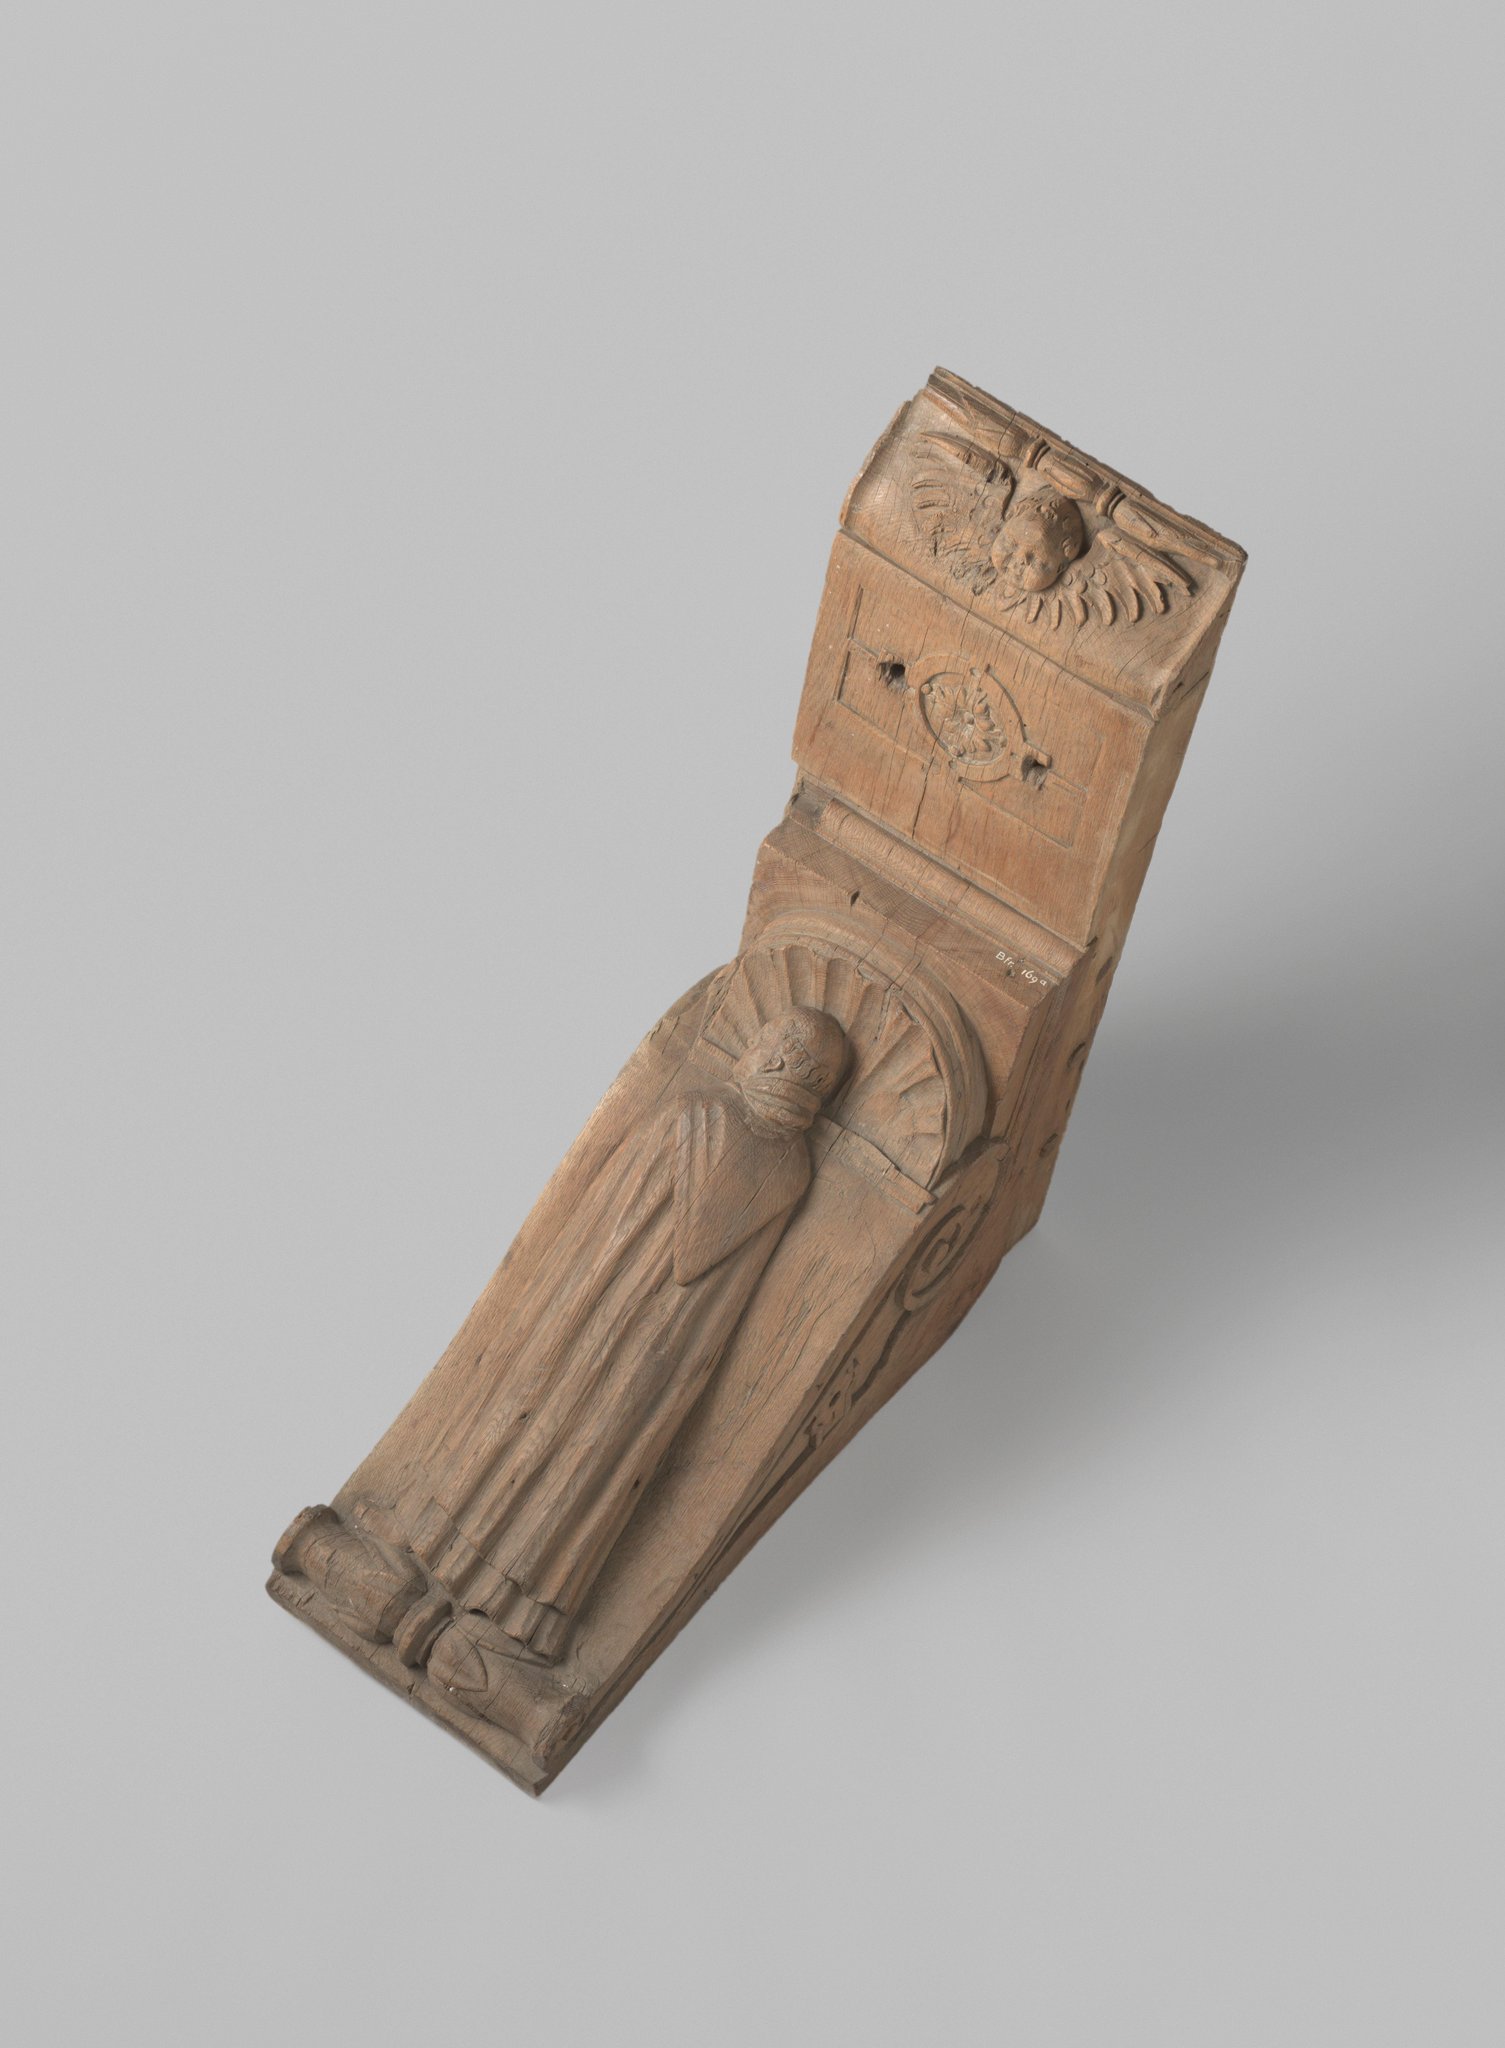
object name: balksleutel, sleutelstuk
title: Korbeel met sleutelstuk, met gesneden voorstelling van een monnik, afkomstig uit het klooster in de Oude Hoogstraat te Amsterdam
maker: Anonymous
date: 1550-1600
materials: wood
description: Korbeel met sleutelstuk van eikenhout. Op het consolevormige voorstuk is in reliëf een monnik voor een schelpnis gebeeldhouwd. De zijkanten vertonen een voluut met rolwerk. Het sleutelstuk is versierd met een engelenkop. Afkomstig uit het klooster in de Oude Hoogstraat te Amsterdam.